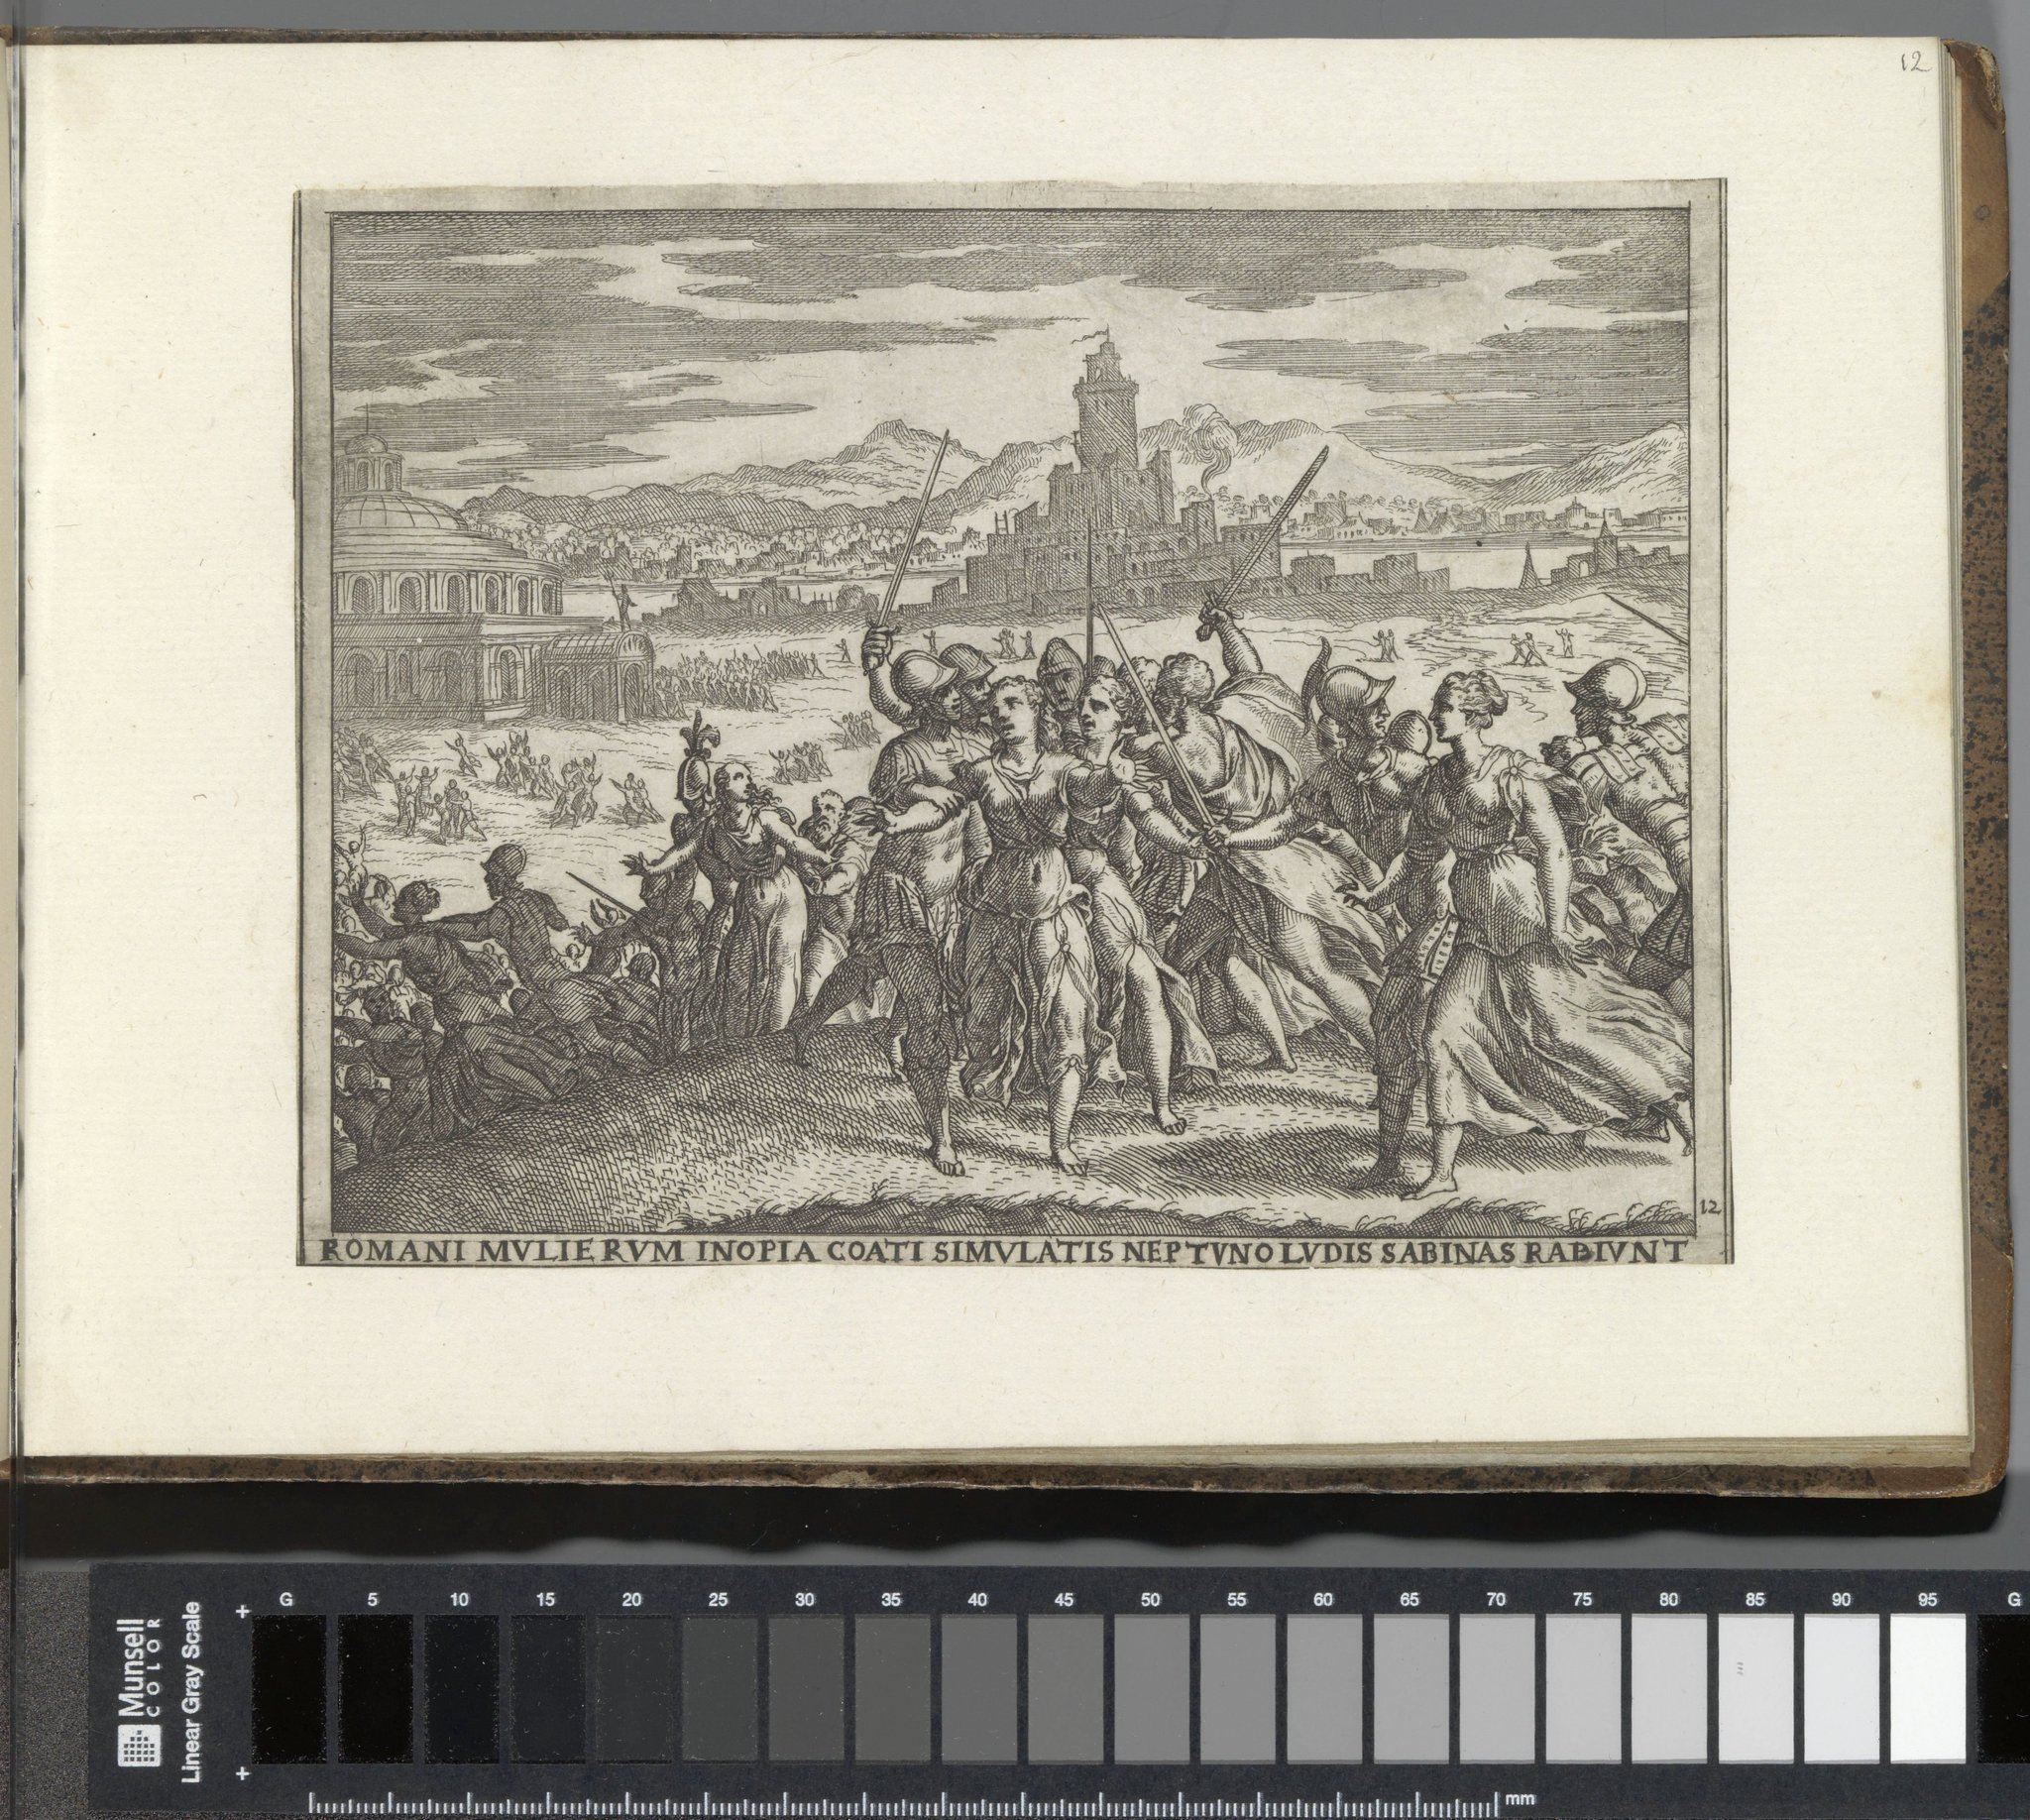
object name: album leaf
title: Leven van Romulus en Remus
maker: giovanni battista fontana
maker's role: draughtsman, painter, print maker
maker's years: 1524-1587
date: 1572-1573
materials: paper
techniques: etching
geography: italy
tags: rape of the sabine women: they are carried off by romulus and his men during a feast, (story of) romulus and remus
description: Sabijnse maagden worden weggevoerd door de soldaten van Romulus. De prent maakt deel uit van een album.